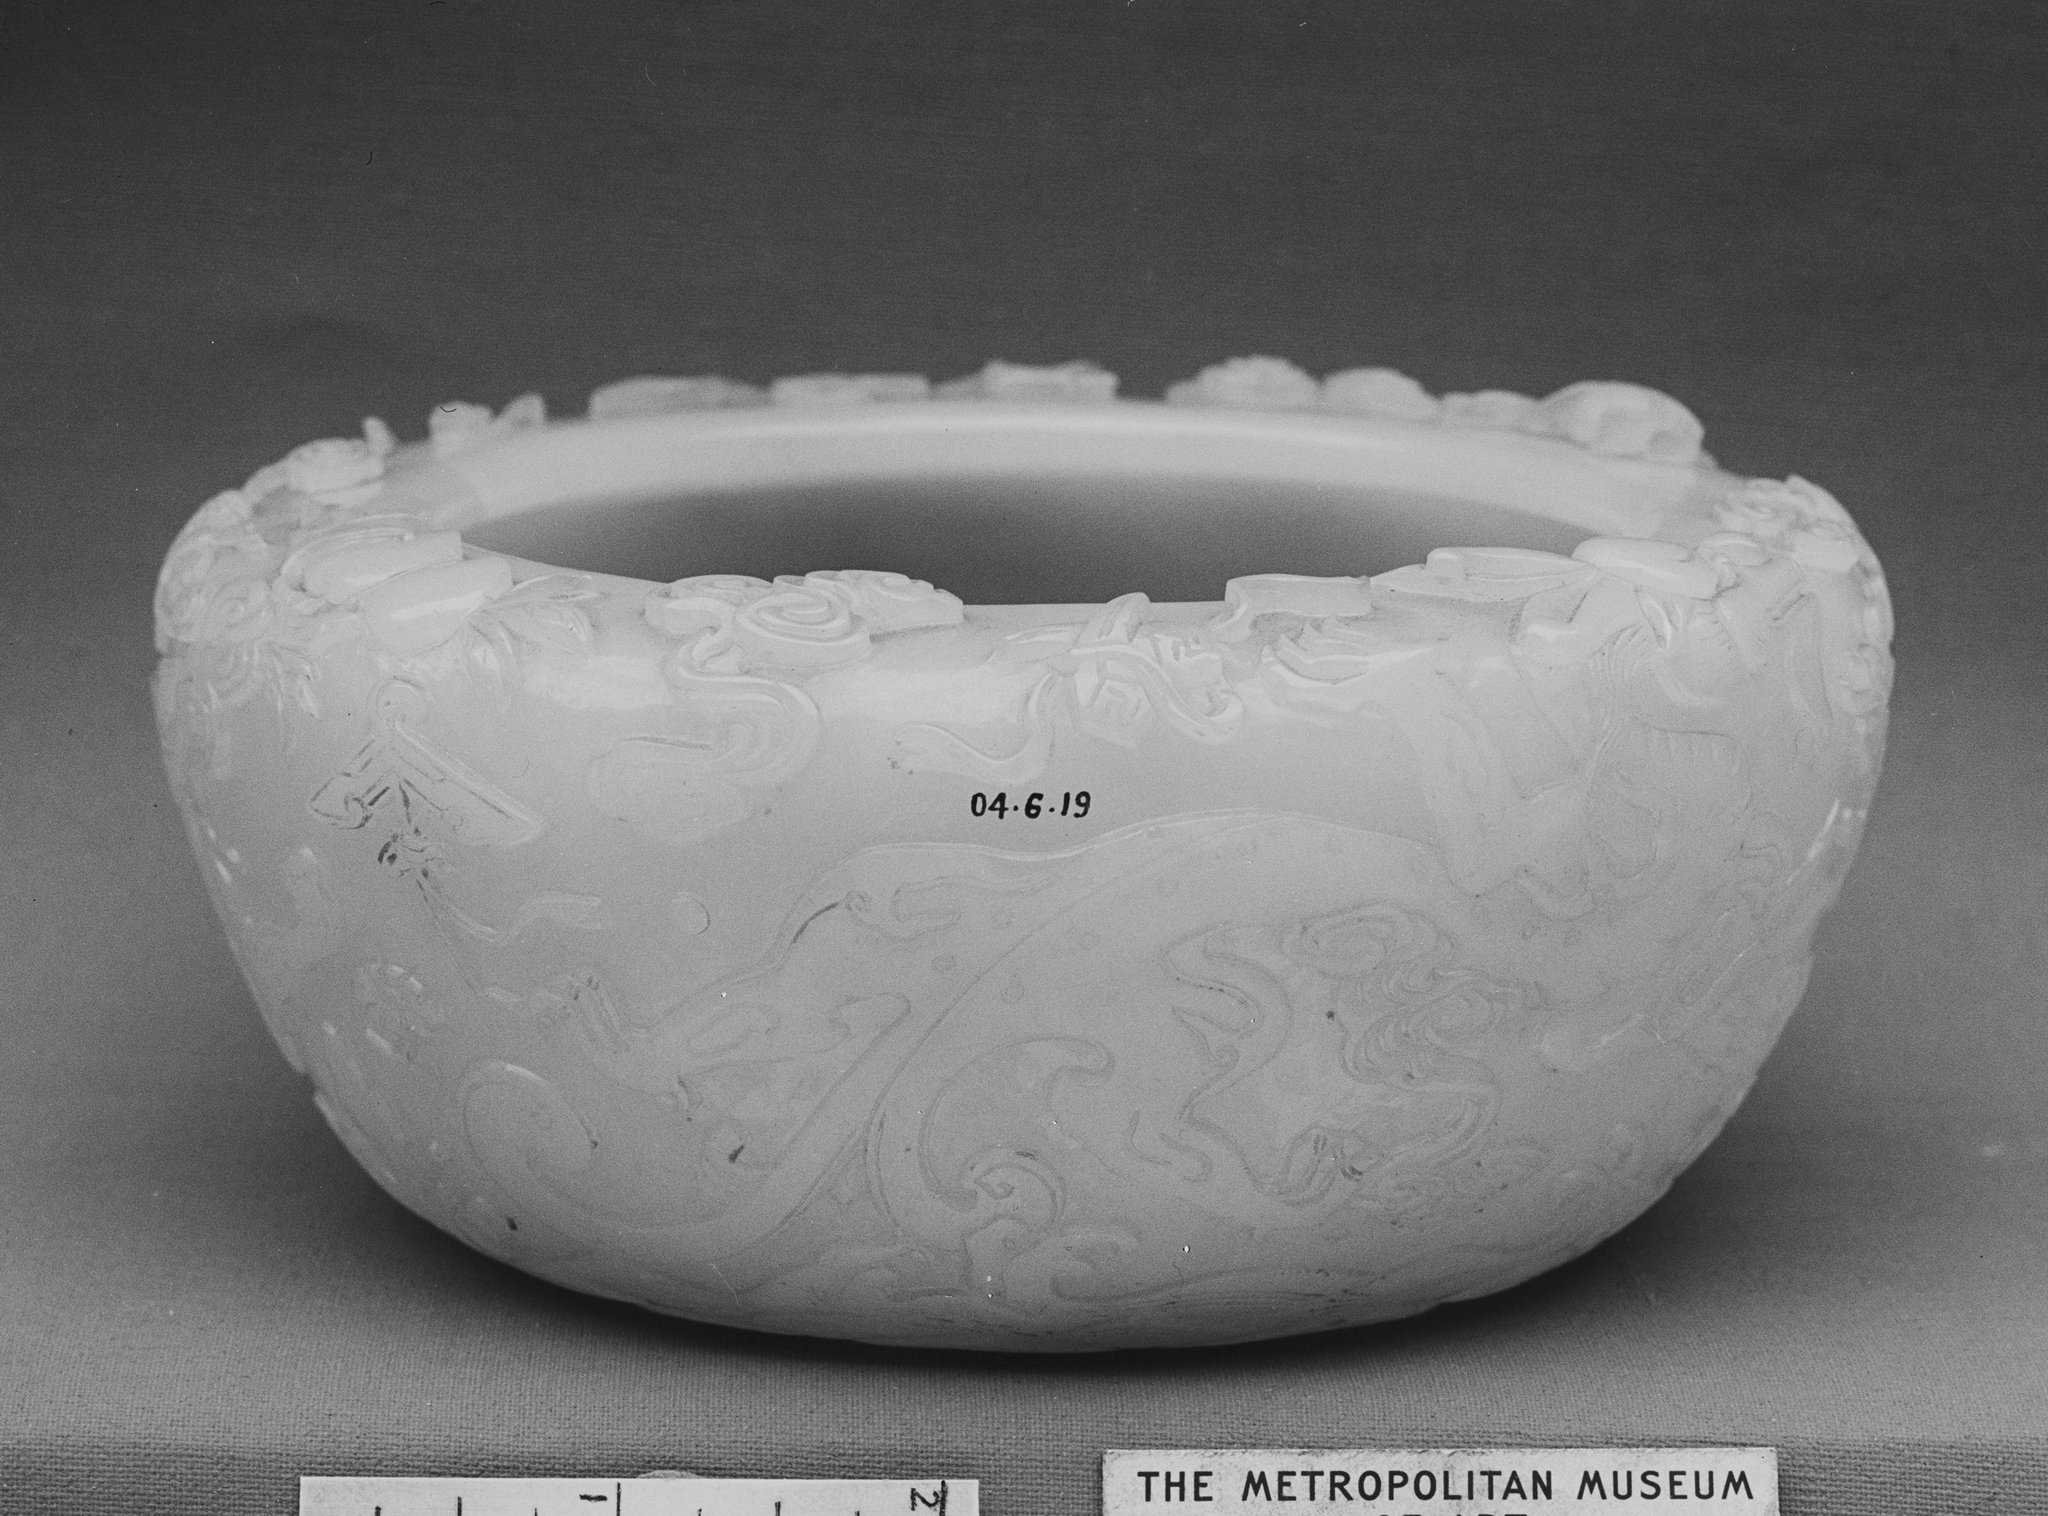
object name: bowl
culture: chinese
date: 1736-1795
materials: jade